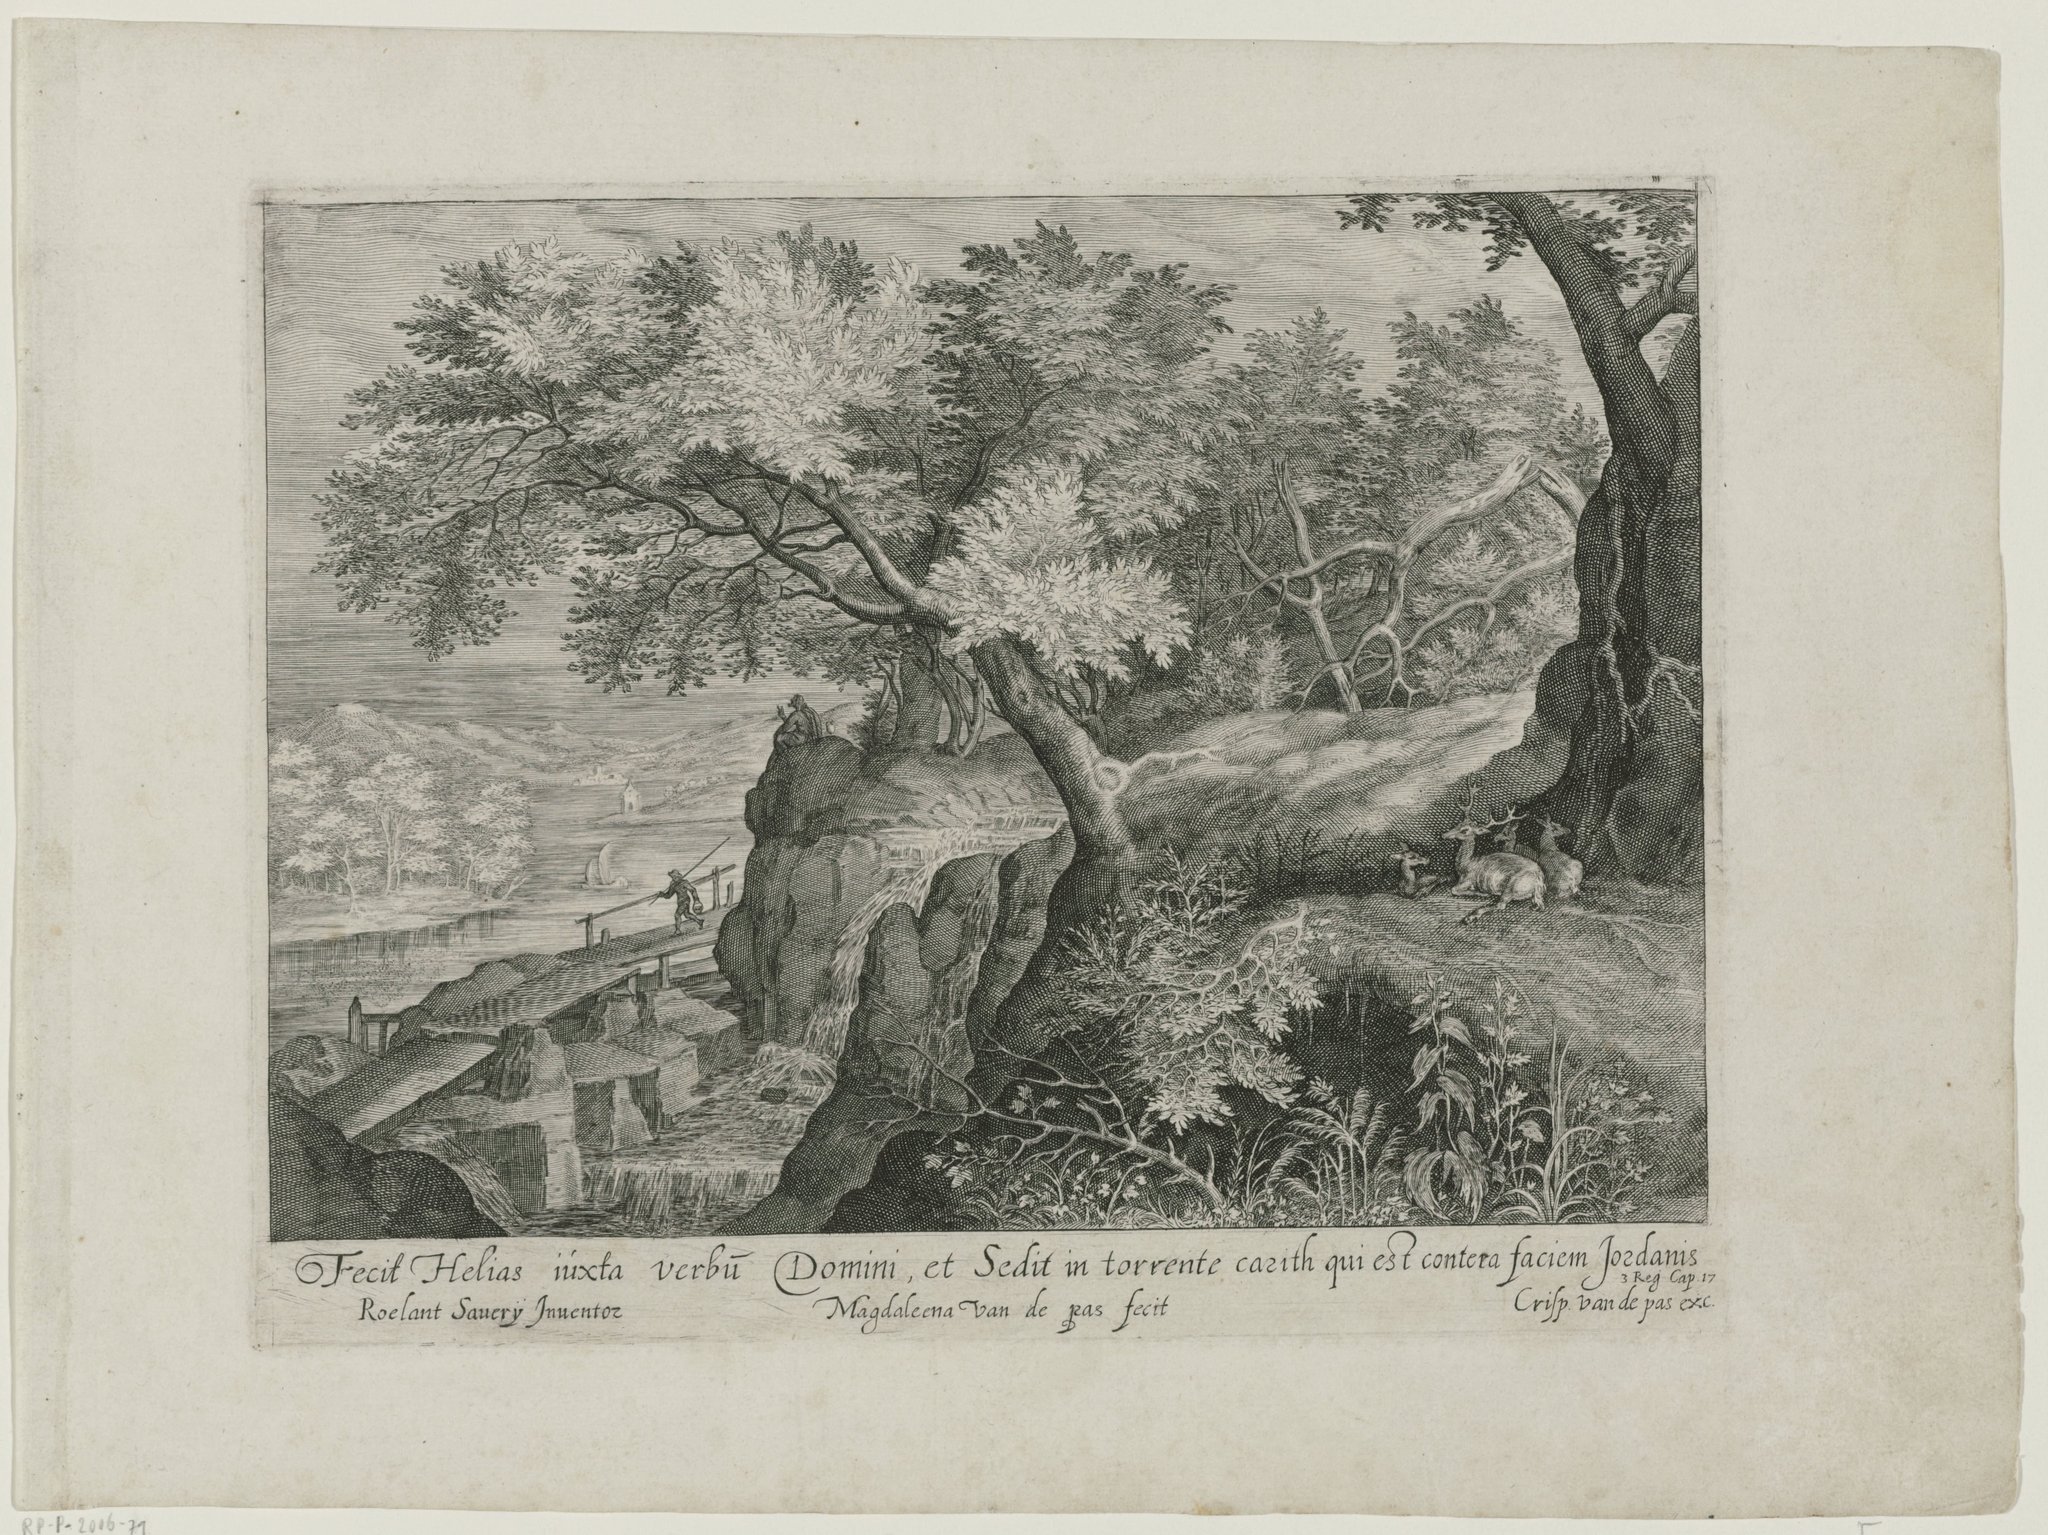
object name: print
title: Landscapes with the Story of Elijah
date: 1617-1634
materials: paper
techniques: engraving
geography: utrecht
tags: elijah at the brook cherith (1 kings 17:1-6), forest, wood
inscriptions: collector's mark: Lugt 2228, collector's mark: Lugt 2760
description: Magdalena de Passe based these impressive landscapes on paintings by the landscape painters Adam Willaerts and Roelant Savery. On her own initiative, the printmaker turned them into a narrative series by incorporating in them scenes from the life of the prophet Elijah. De Passe’s subtle engraving technique comes into its own in the rocky outcrops, waters and rolling hills. You can almost distinguish each leaf in the foliage of the trees.